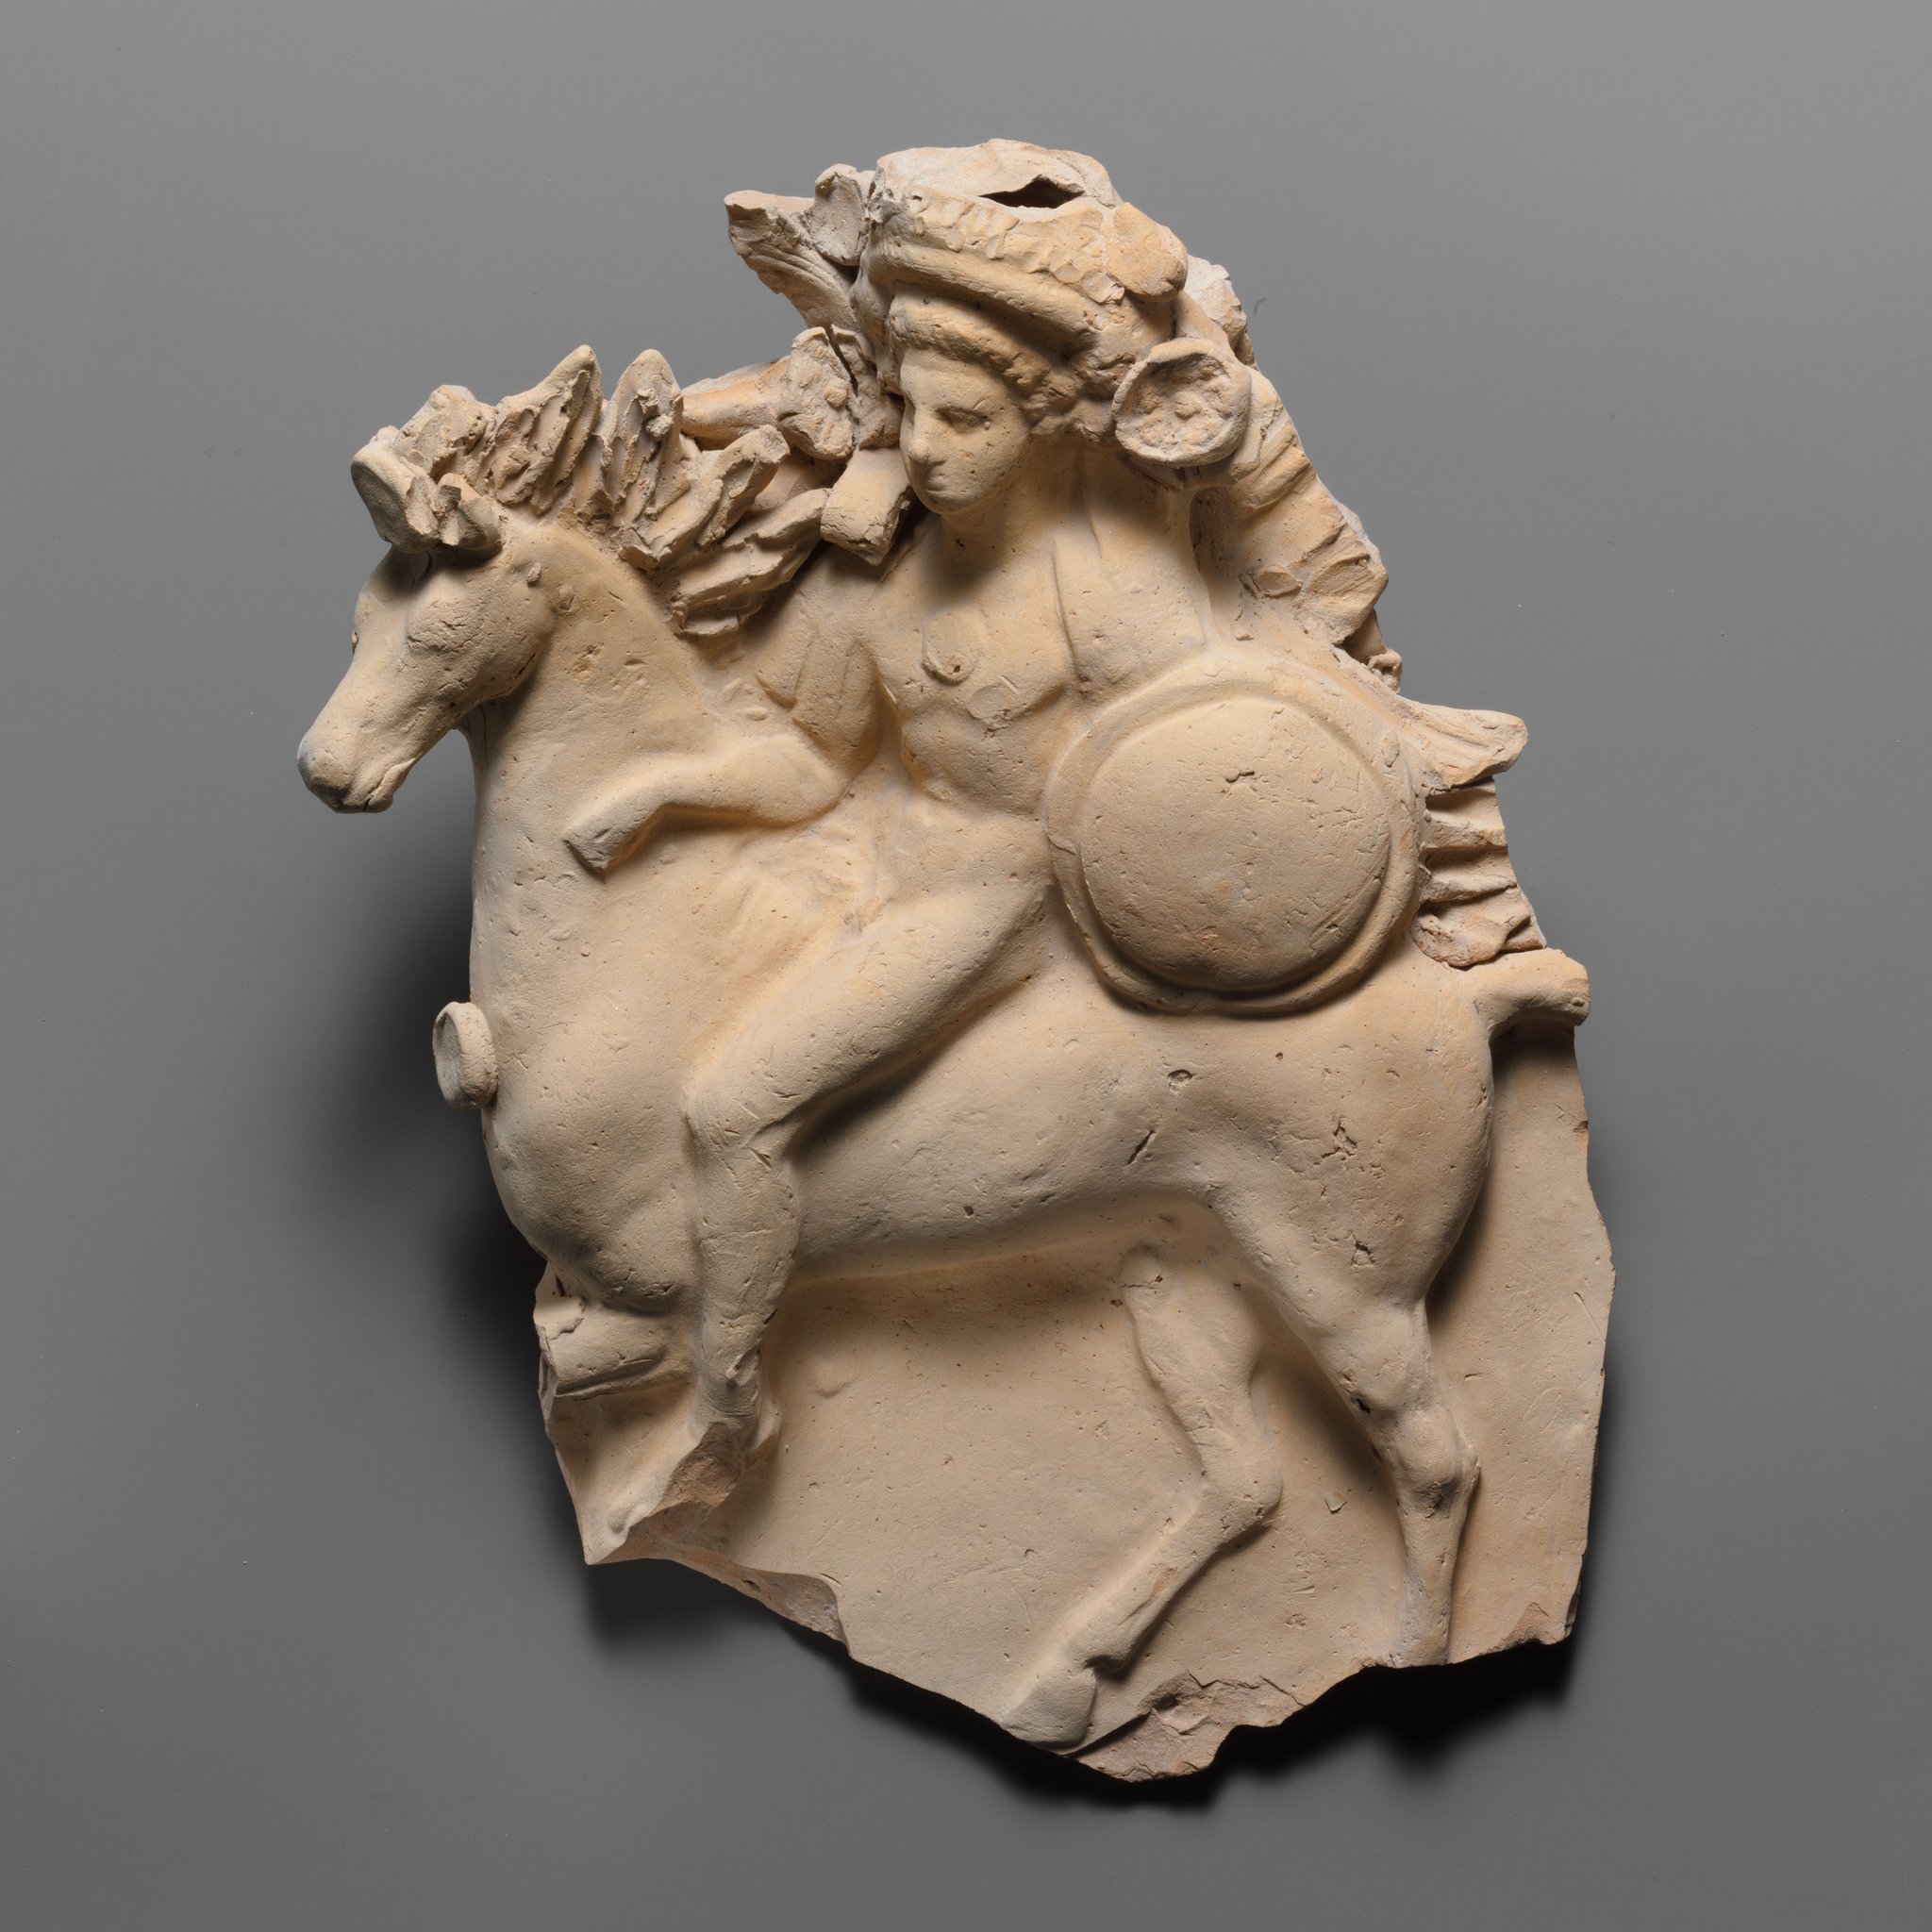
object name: relief of a horseman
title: Terracotta relief of a horseman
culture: greek, south italian, tarentine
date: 400-301 BCE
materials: terracotta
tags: shields,male nudes,horses